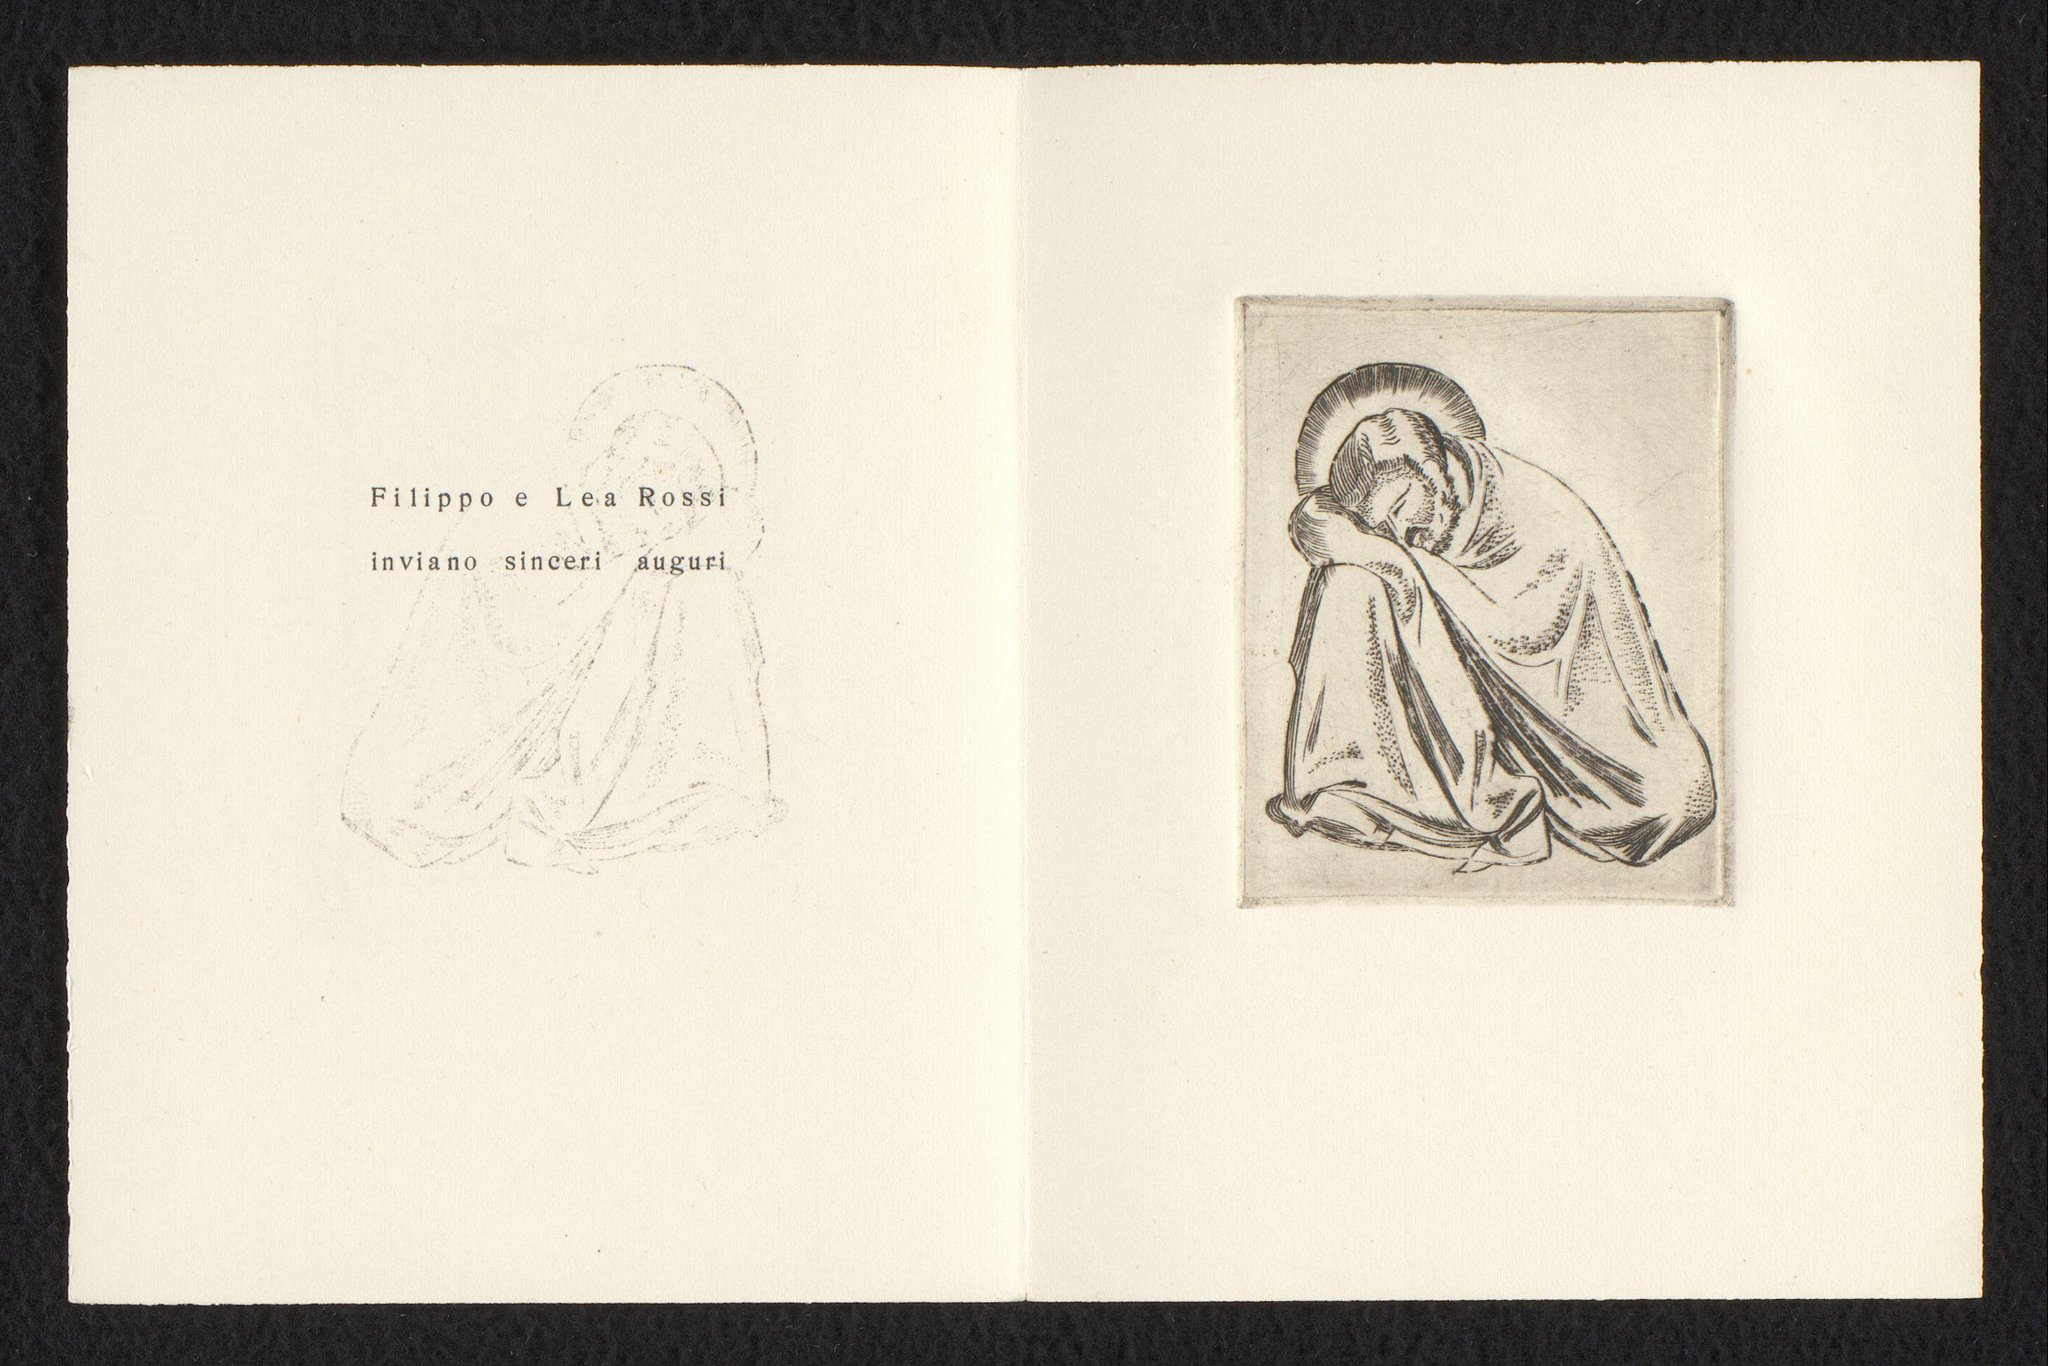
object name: print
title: Kerst- en nieuwjaarswens van Filippo en Lea Rossi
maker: Anonymous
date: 1930-1980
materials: paper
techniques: etching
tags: christmas card, christ as adult